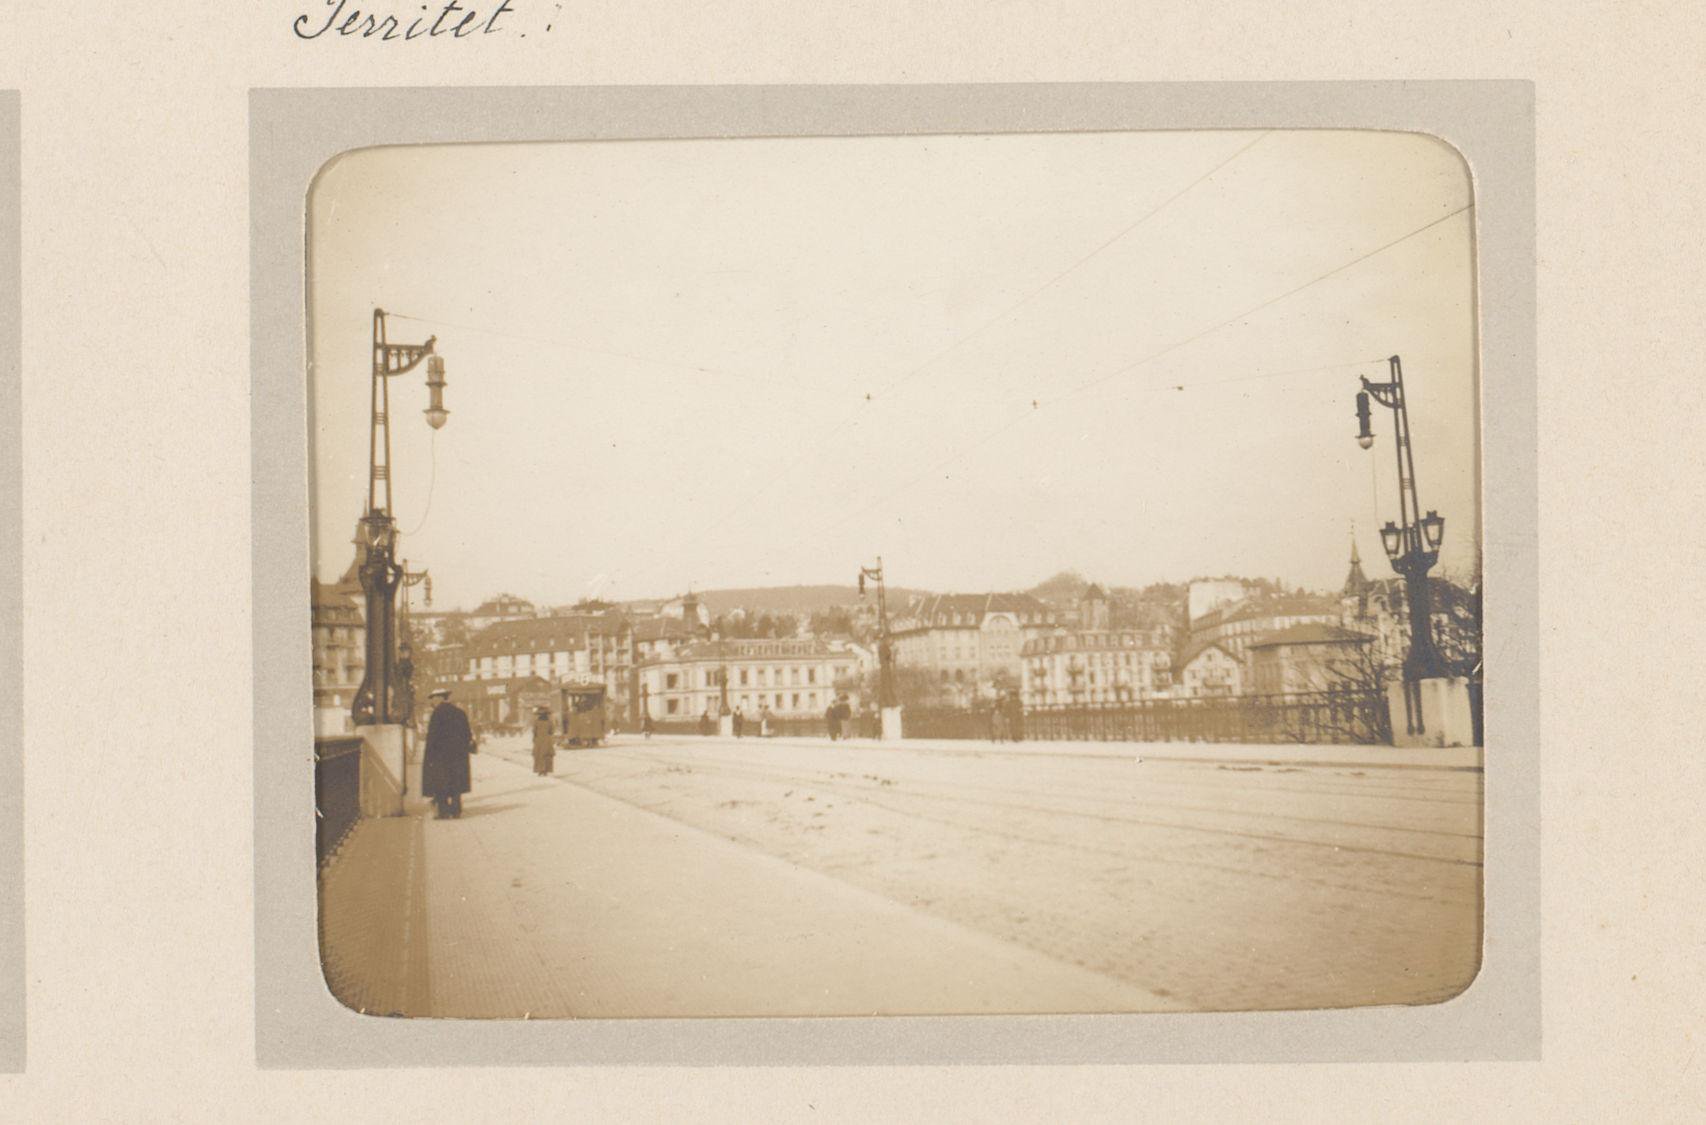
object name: photograph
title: Gezicht op een brede brug waarover een electrische tram rijdt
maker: liesbeth overhoff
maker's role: fotograaf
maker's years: 1895-1969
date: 1911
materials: paper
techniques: gelatin silver print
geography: territet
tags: tramway, tram, city-view in general; 'veduta', bridge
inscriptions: inscription: ‘1911 - Territet’